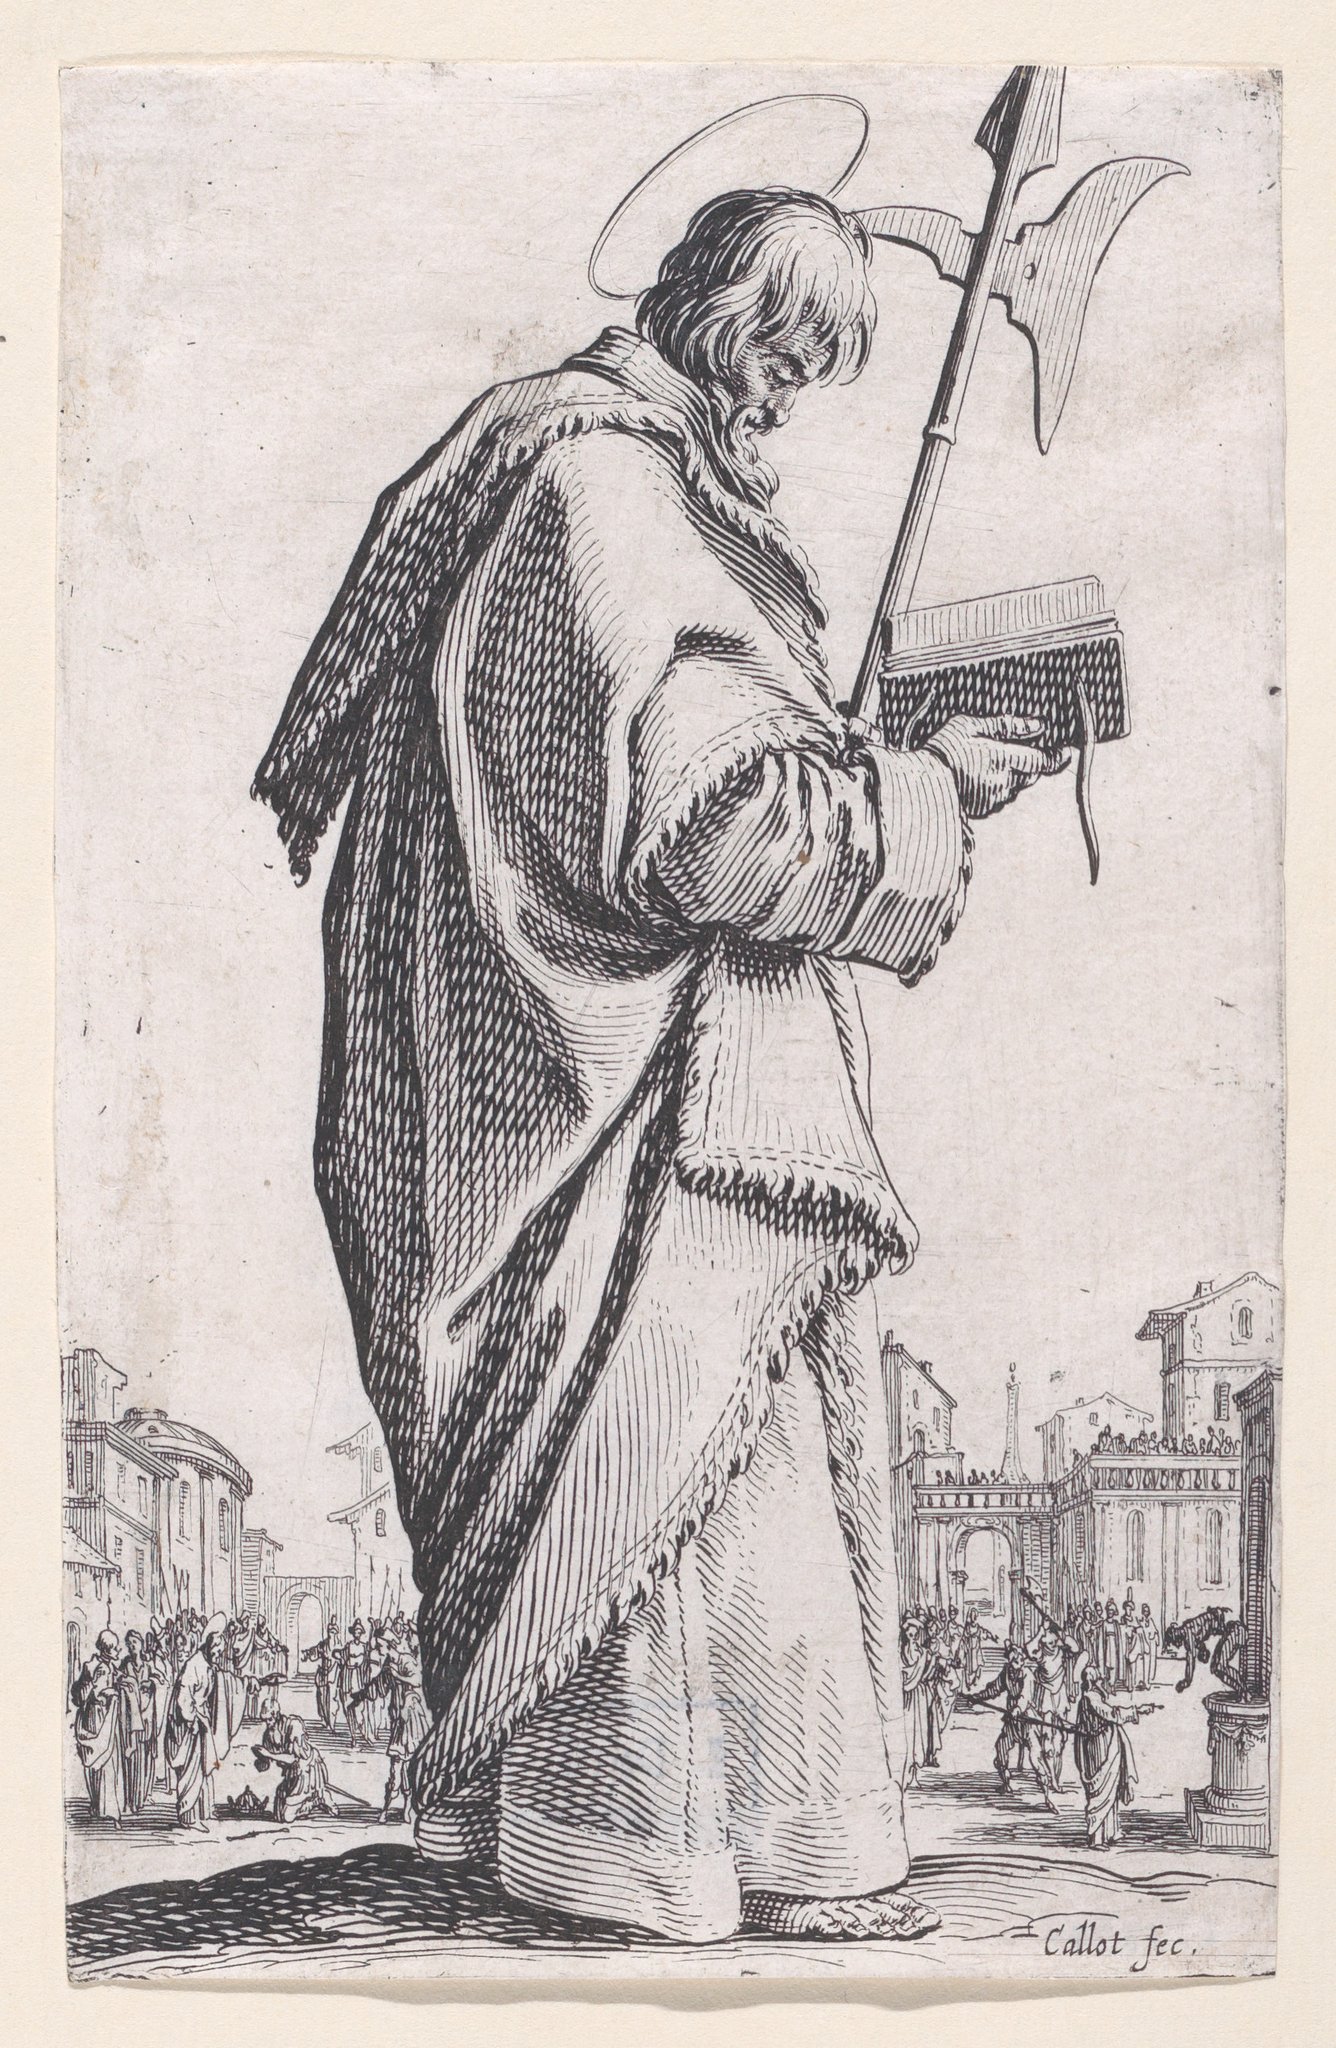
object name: print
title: St. Matthias, from "Les Grands Apôtres Debout, Représentant Le Sauveur, La Bienheureuse Marie et Les Saints Apôtres" (The Large Standing Apostles, Representing The Savior, The Blessed Mary and The Apostles)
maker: jacques callot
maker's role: artist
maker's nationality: french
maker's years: 1592-1635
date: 1631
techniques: etching